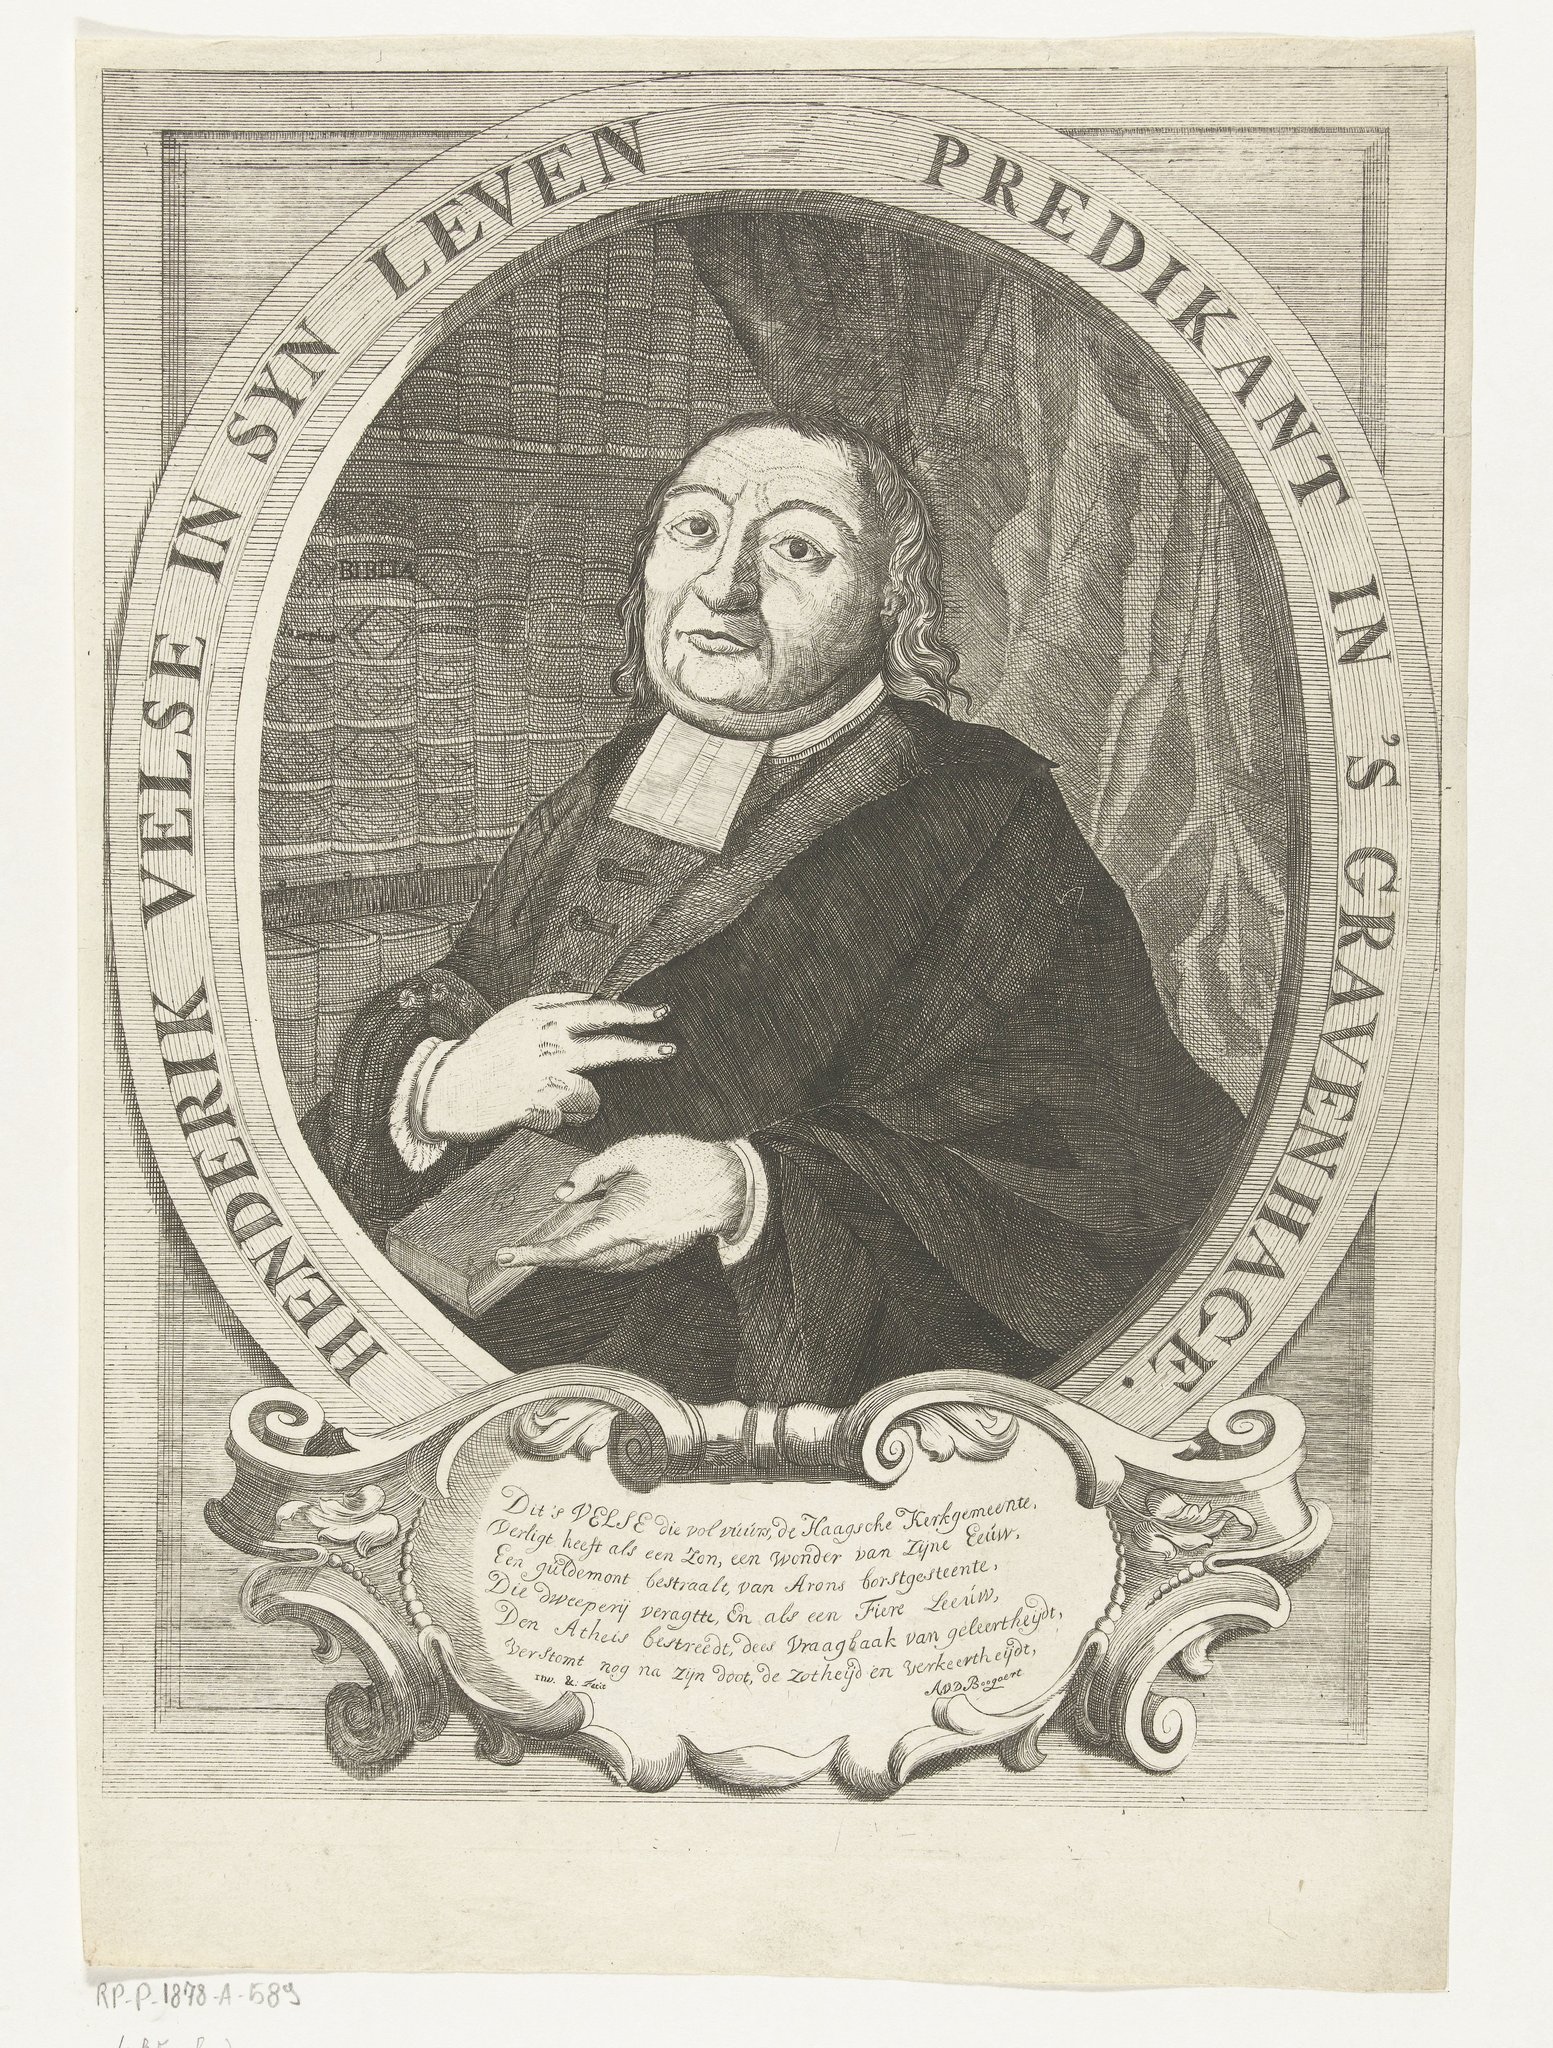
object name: print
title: Portret van Hendrik Velse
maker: a. van den boogaert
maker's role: print maker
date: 1744-1799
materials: paper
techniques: engraving, etching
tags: the hague, historical persons, book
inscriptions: collector's mark: Lugt 2228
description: Portret in een ovale lijst van Hendrik Velse, predikant van de kerkgemeente van Den Haag. Buste naar links. Velse draagt zijn ambtsgewaad en houdt in zijn linkerhand een boek vast. Naast hem staat een bibliotheek met allerhande boeken. Drie boeken dragen een naam: Josephius, Biblia en Eronimus. De cartouche onder het portret draagt een Nederlands onderschrift.